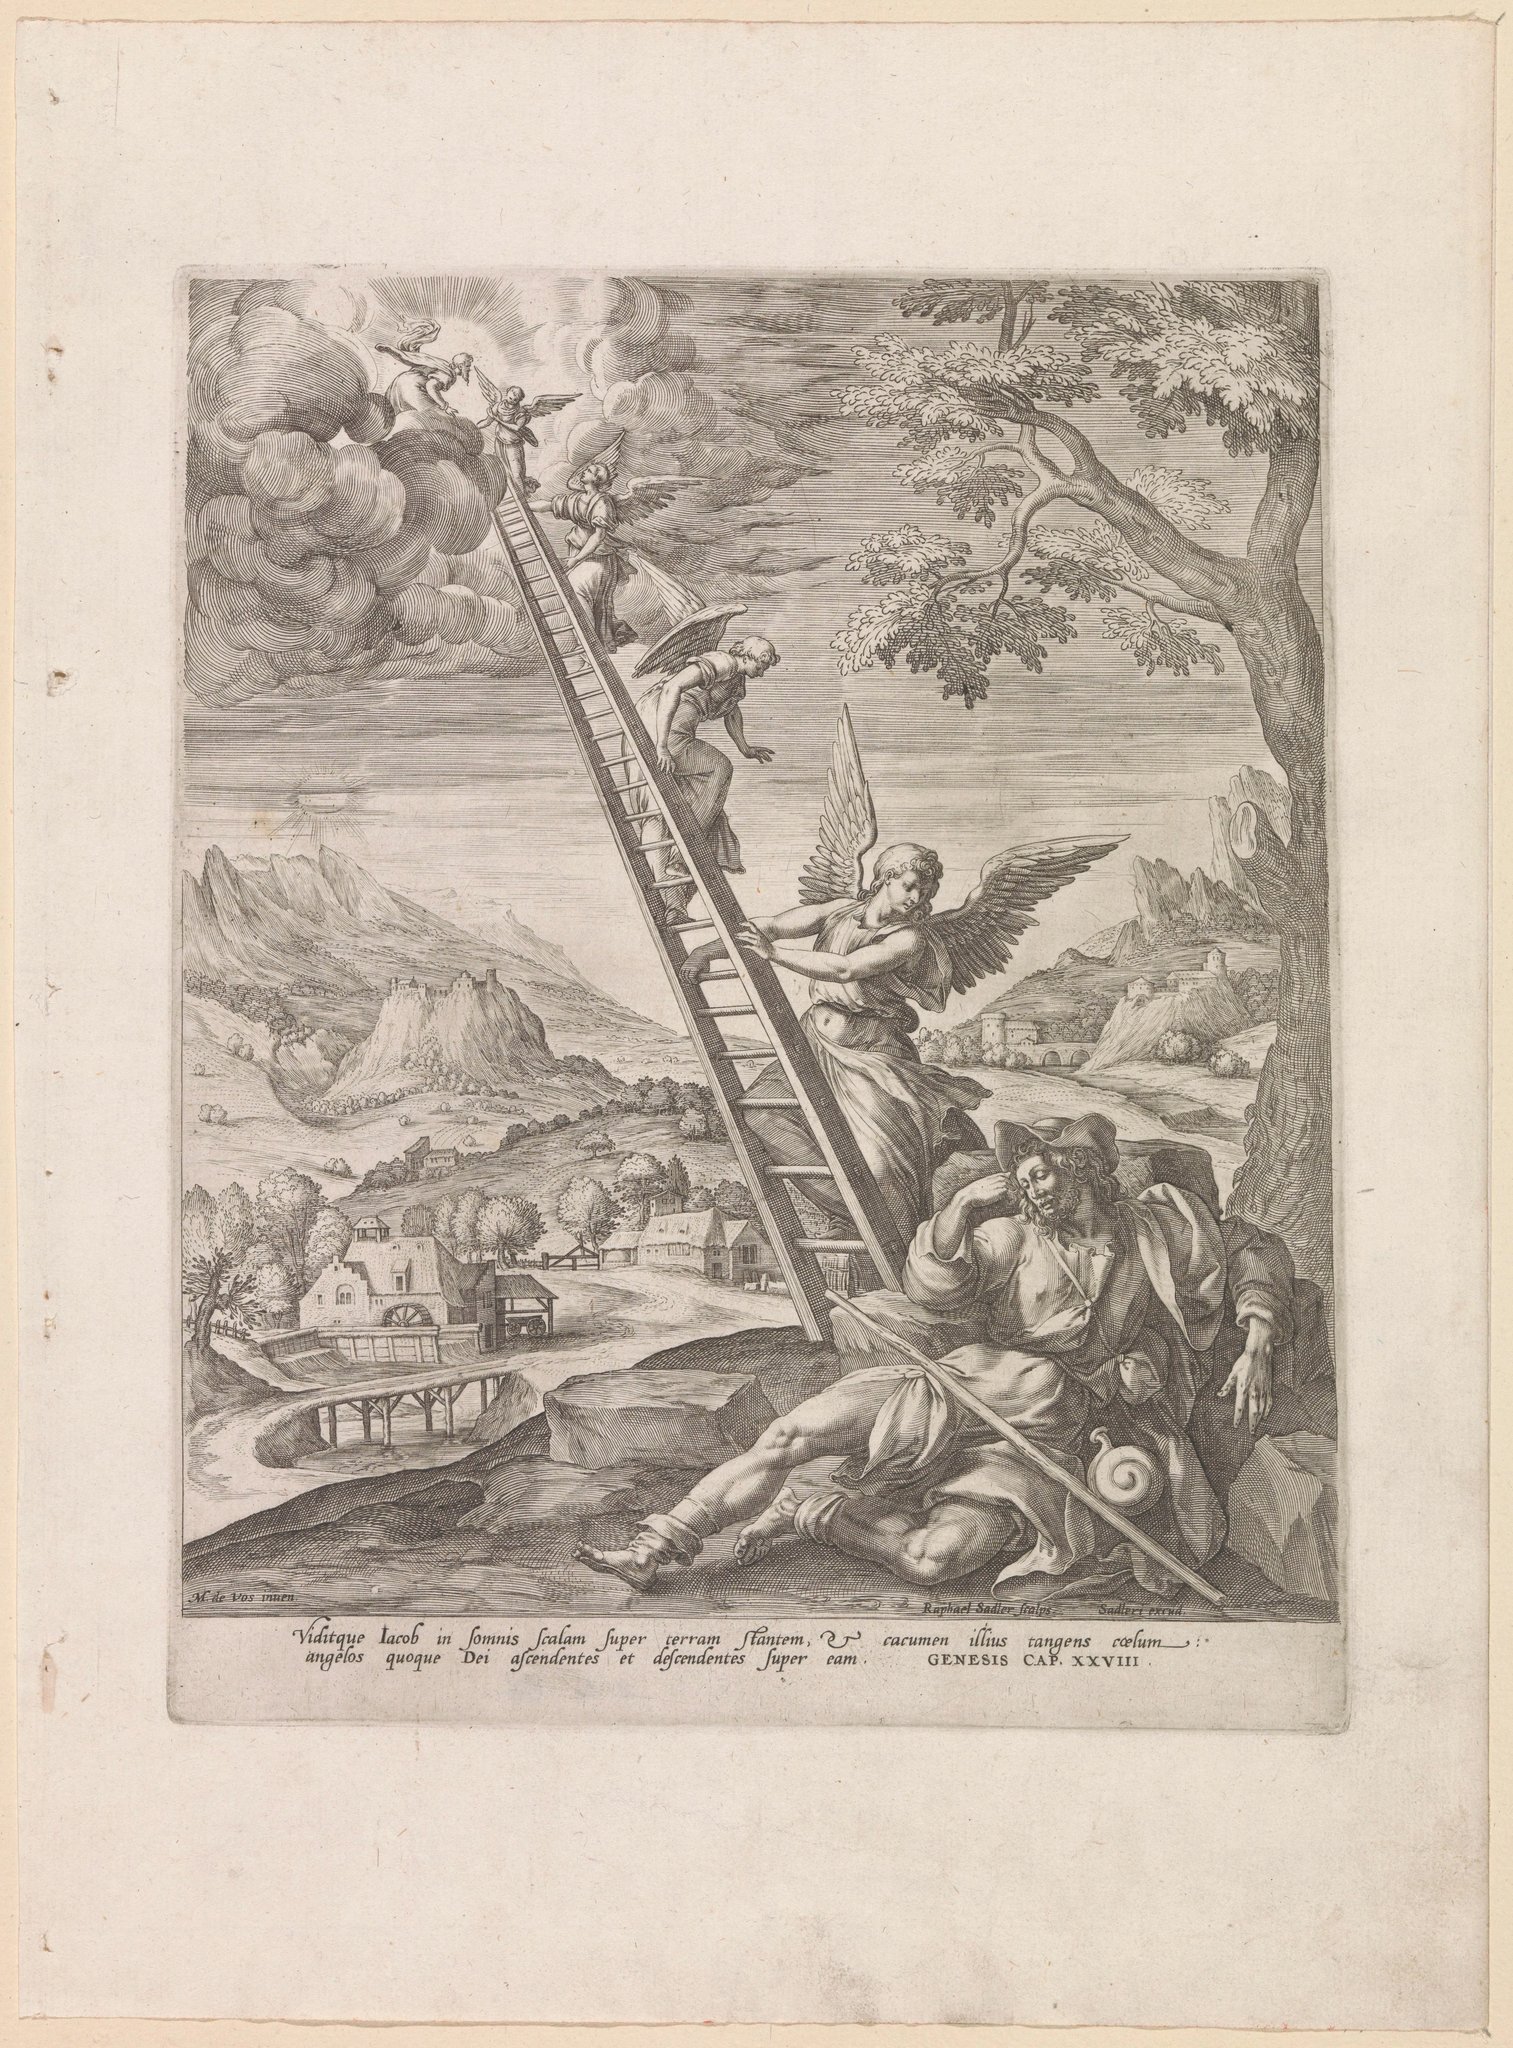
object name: print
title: Jakobs ladder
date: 1580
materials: paper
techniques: engraving, etching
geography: cologne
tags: the dream of jacob: while sleeping on the ground with a stone for pillow jacob sees a ladder reaching from earth to heaven with angels going up and down; usually with god at the top of the ladder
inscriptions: collector's mark: Lugt 2228, collector's mark: Lugt 2760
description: Jakob ligt tegen een steen te slapen en droomt van een ladder die naar de hemel reikt. Engelen klimmen de ladder op en af. Bovenaan staat God. De zesde prent uit een negendelige serie met scènes uit het Oude Testament.